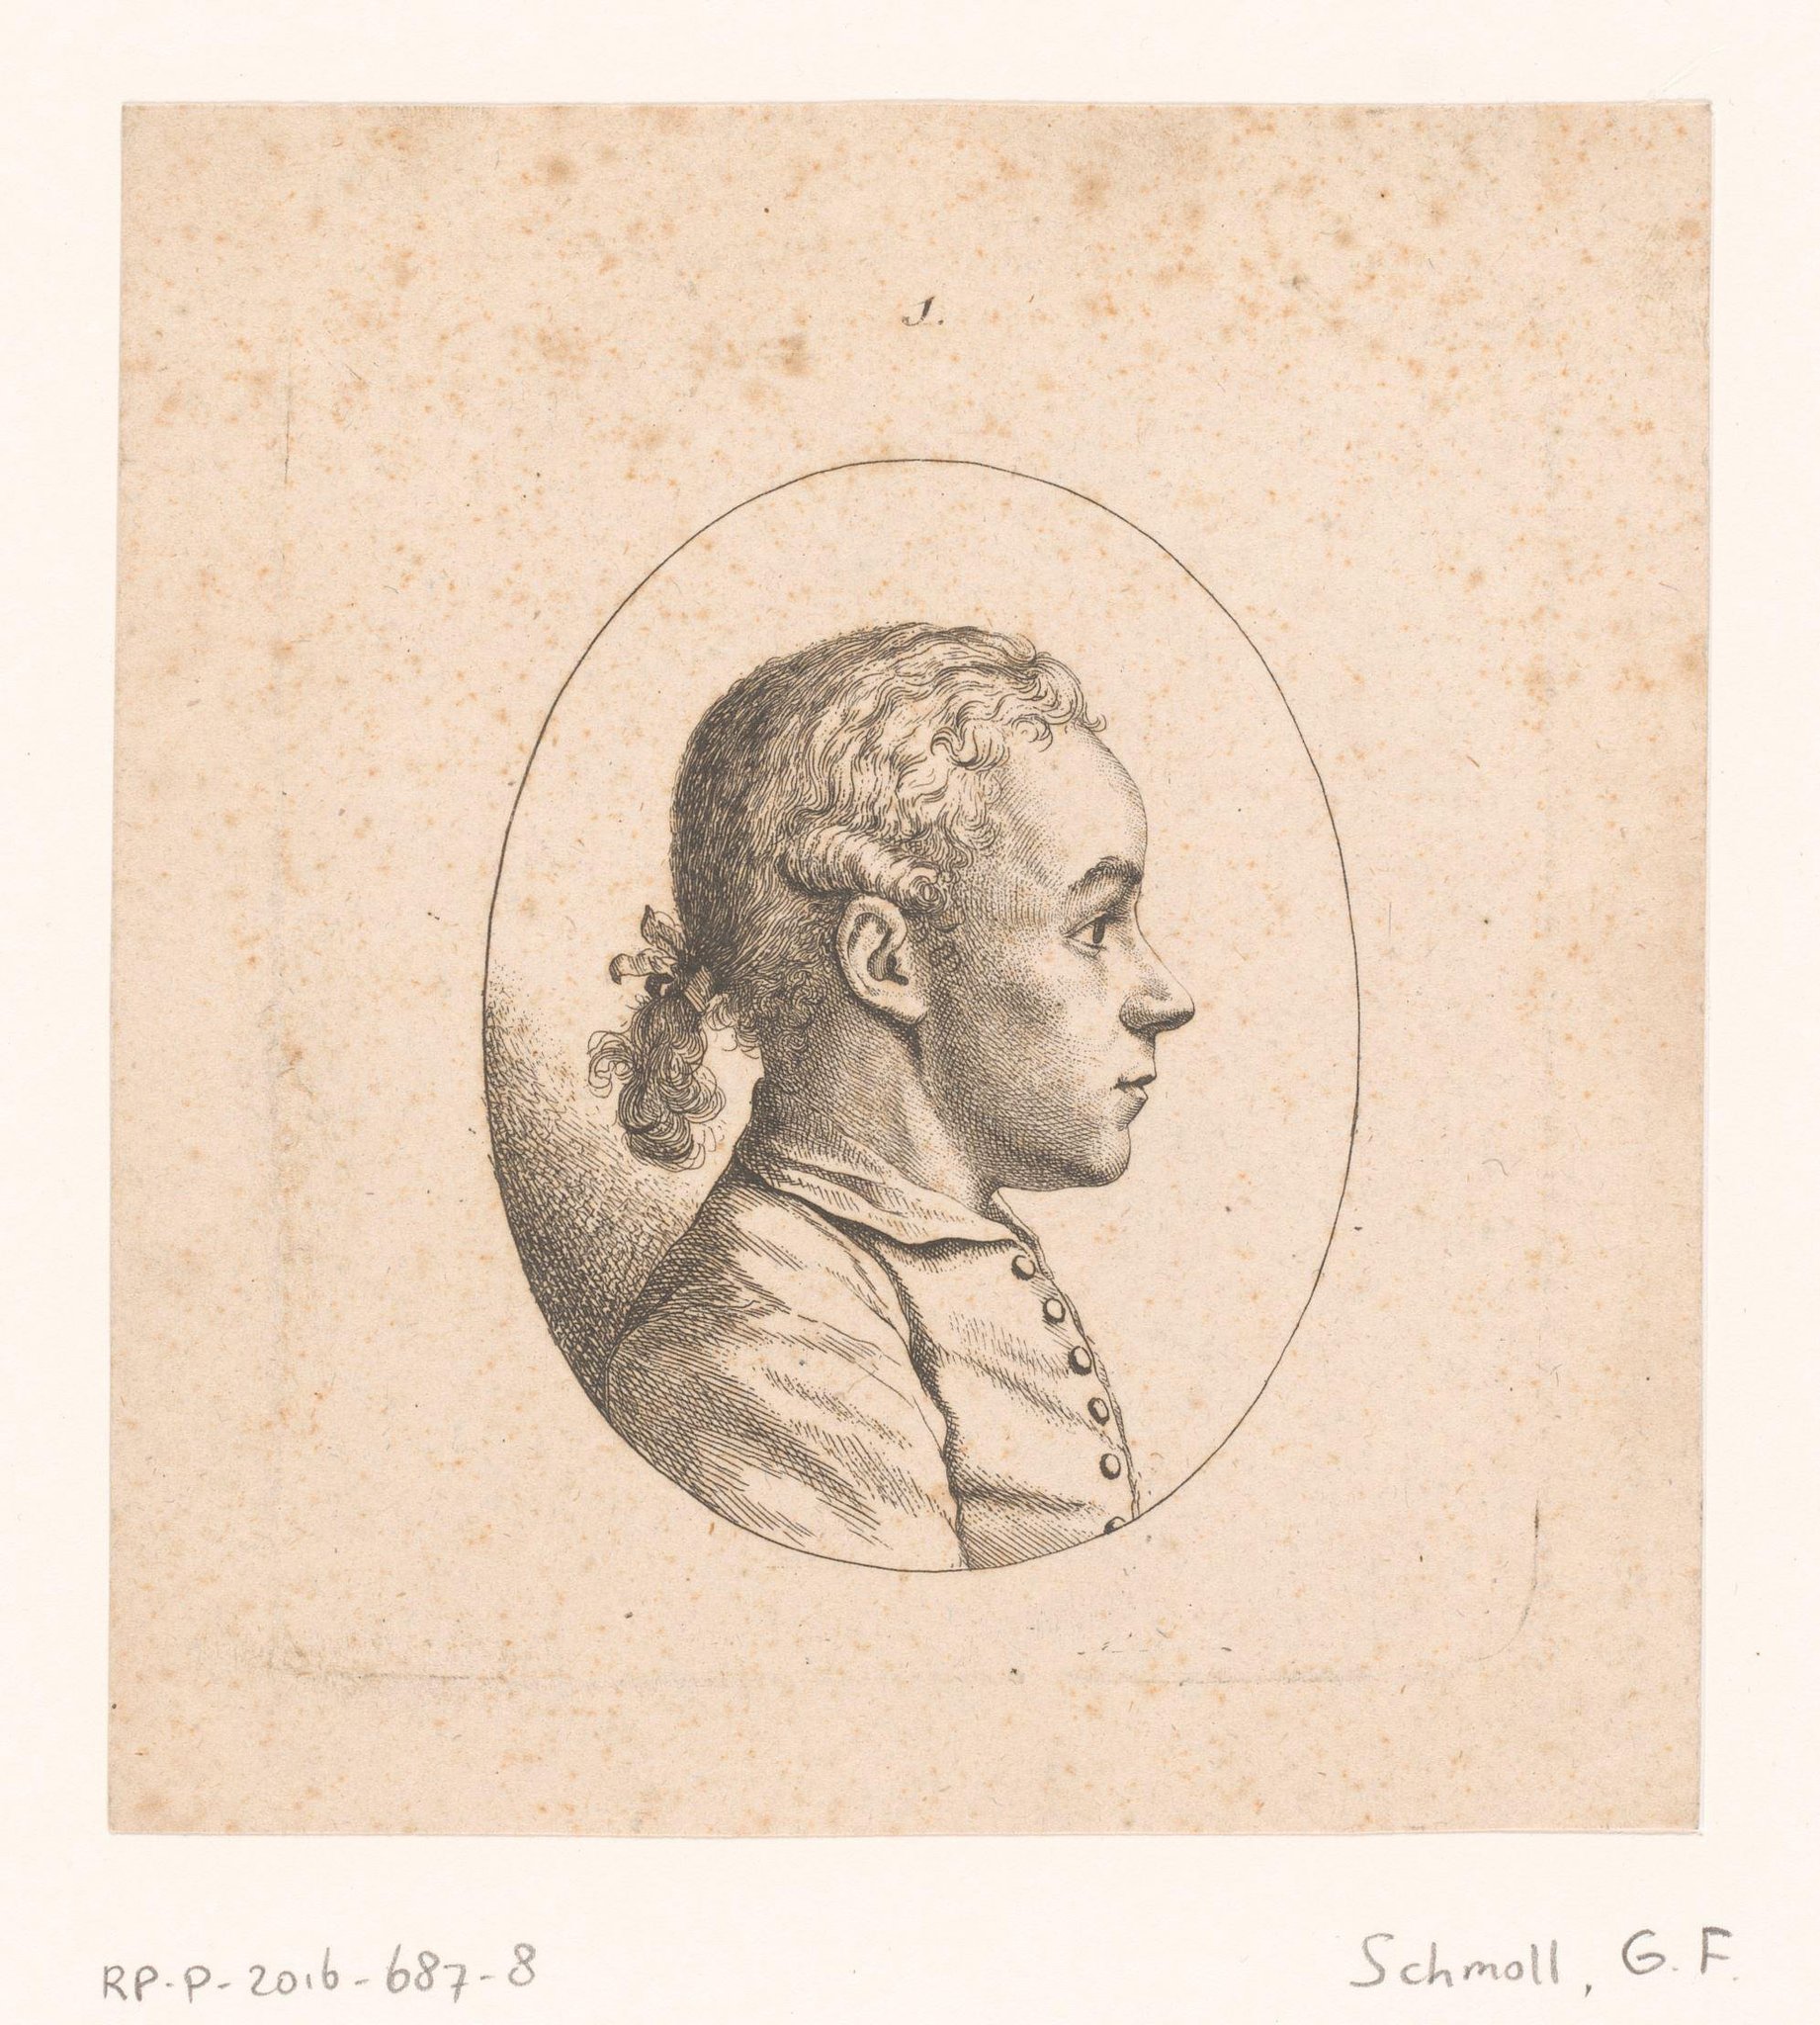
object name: print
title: Portret van Peter im Baumgarten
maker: georg friedrich schmoll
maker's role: draughtsman, print maker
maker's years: 1700-1785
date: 1700-1785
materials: paper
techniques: engraving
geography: germany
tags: historical persons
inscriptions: collector's mark: Lugt 2228, collector's mark: Lugt 2760